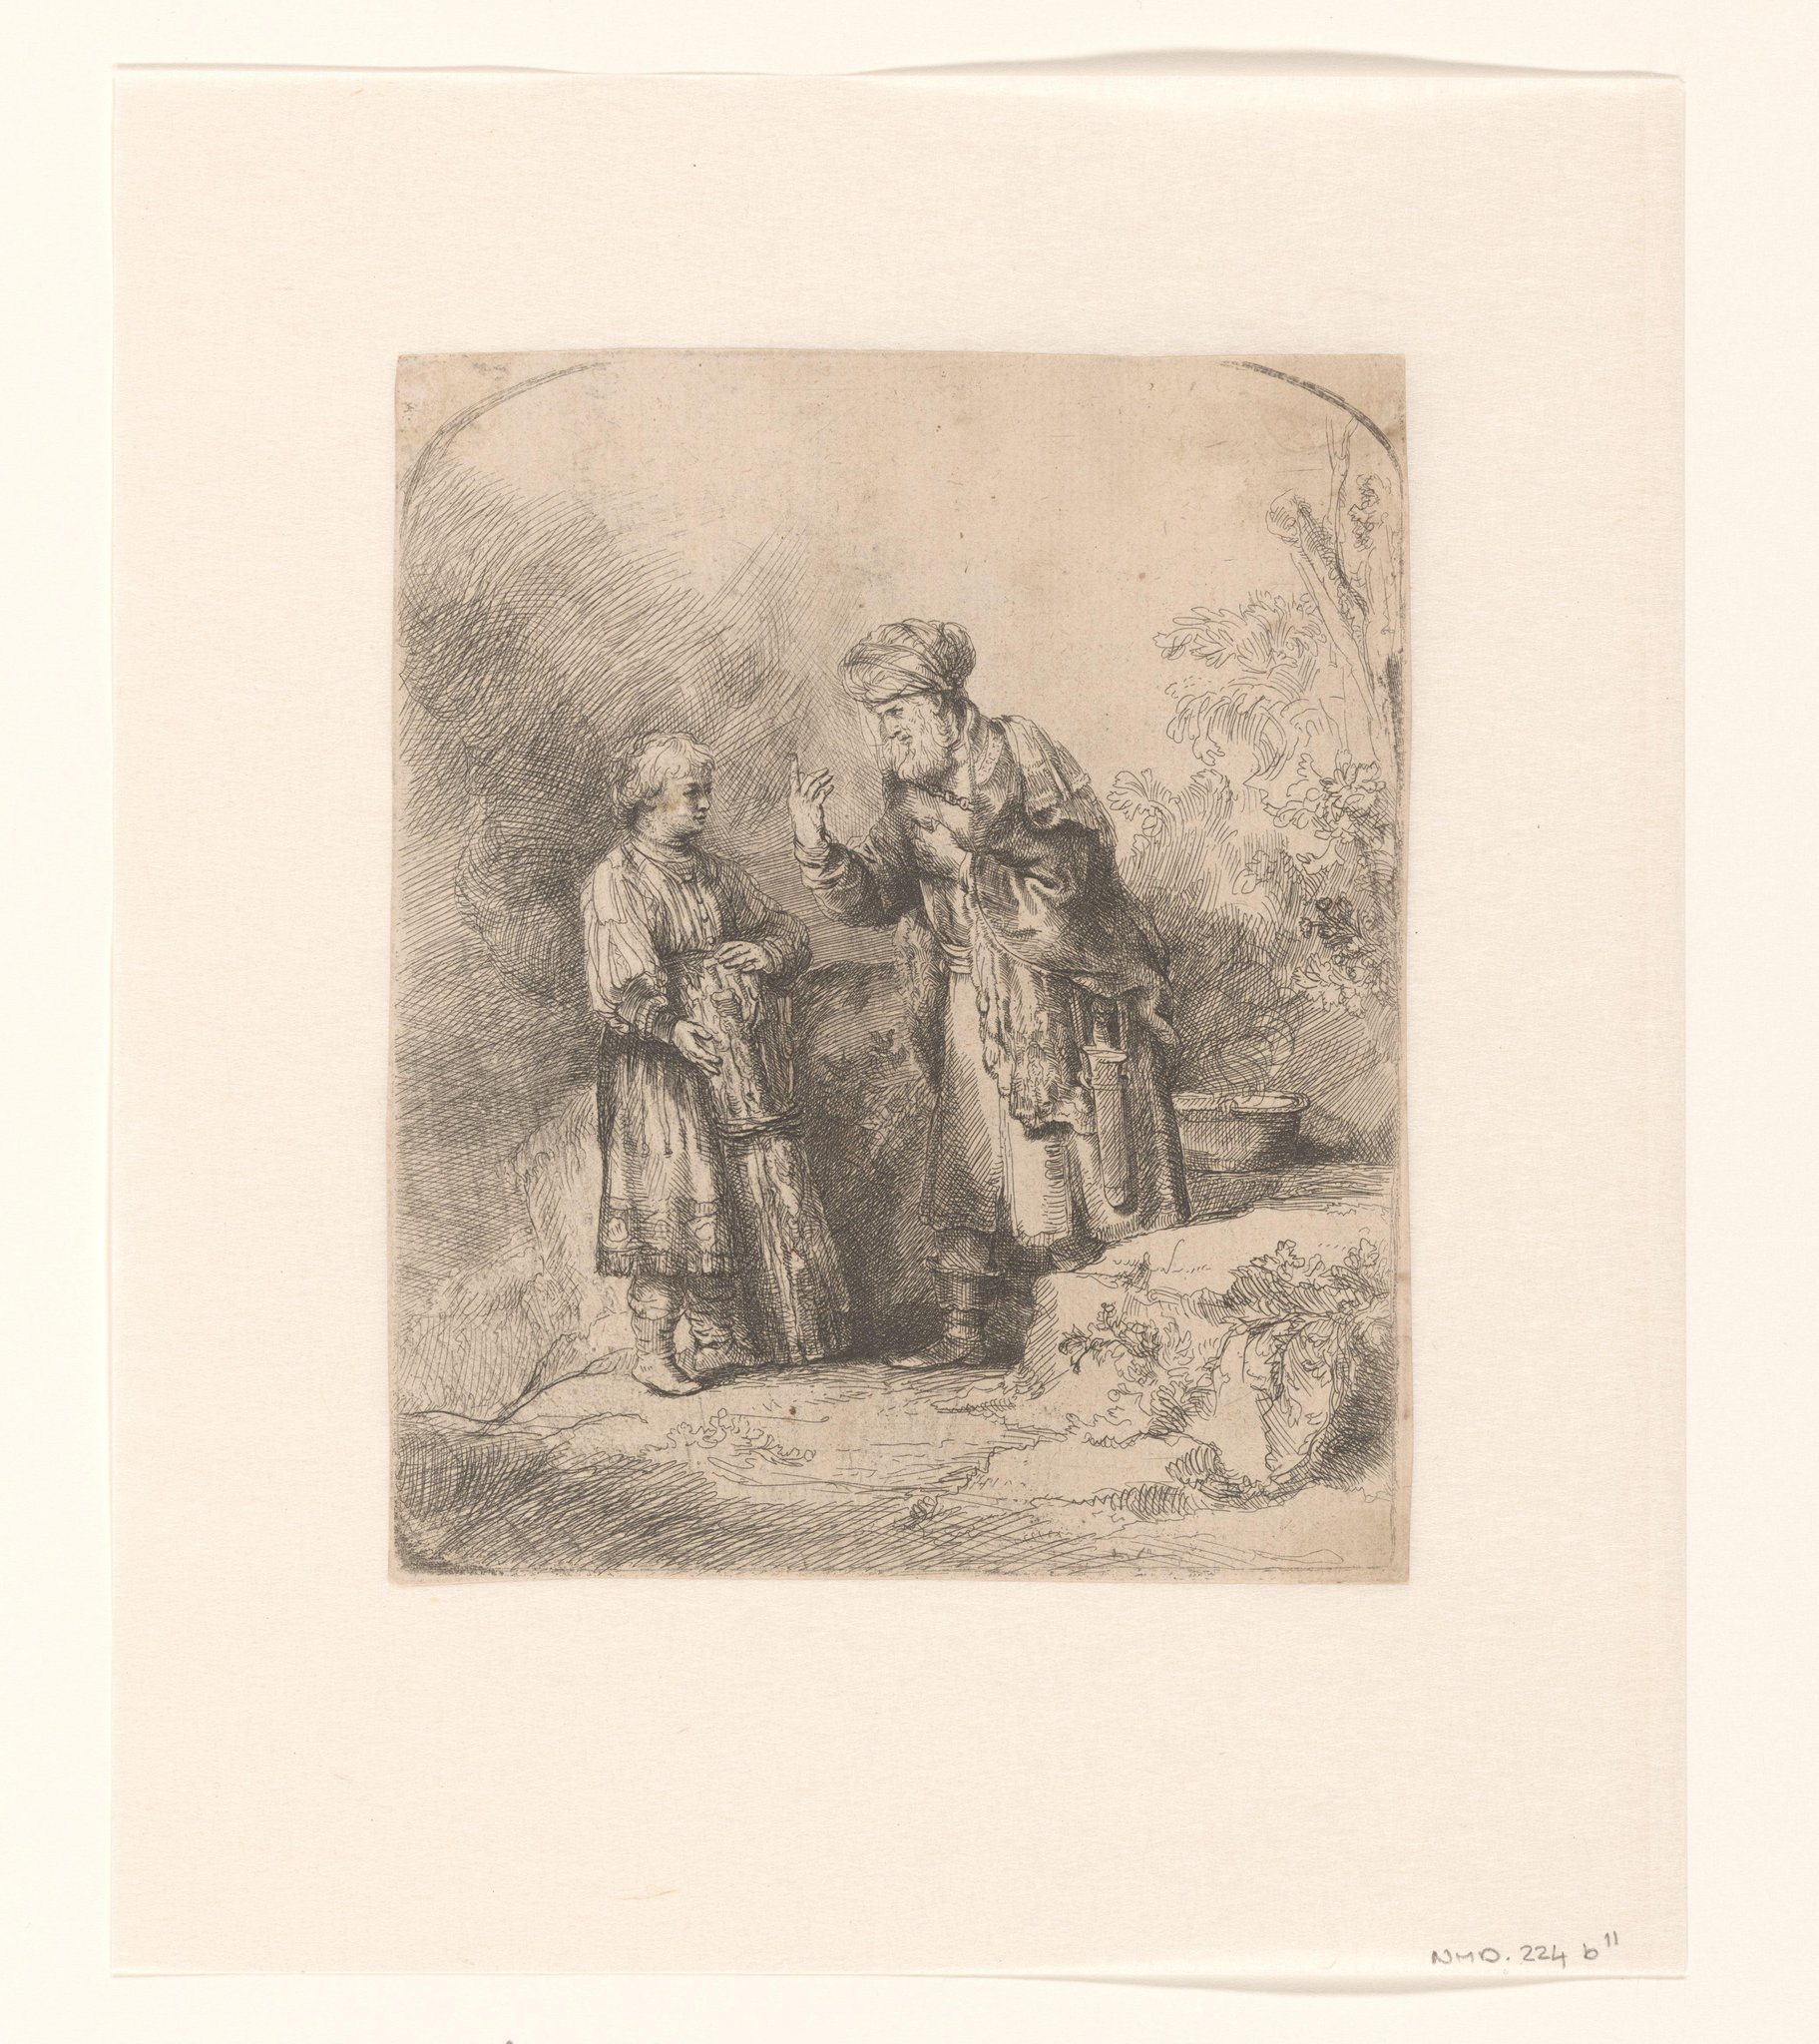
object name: print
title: Abraham and Isaac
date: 1819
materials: paper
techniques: etching, intaglio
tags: story of abraham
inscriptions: collector's mark: Lugt 2228, collector's mark: Lugt 2760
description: Spiegelbeeldige kopie naar de gelijknamige prent van Rembrandt. Prent voor het eerst gebruikt in: Recueil de Quatre-Vingt-Cinq estampes originales, têtes, paysages et différens sujets, dessinées et gravées par Rembrandt. Parijs: Henry Louis Basan, 1819.